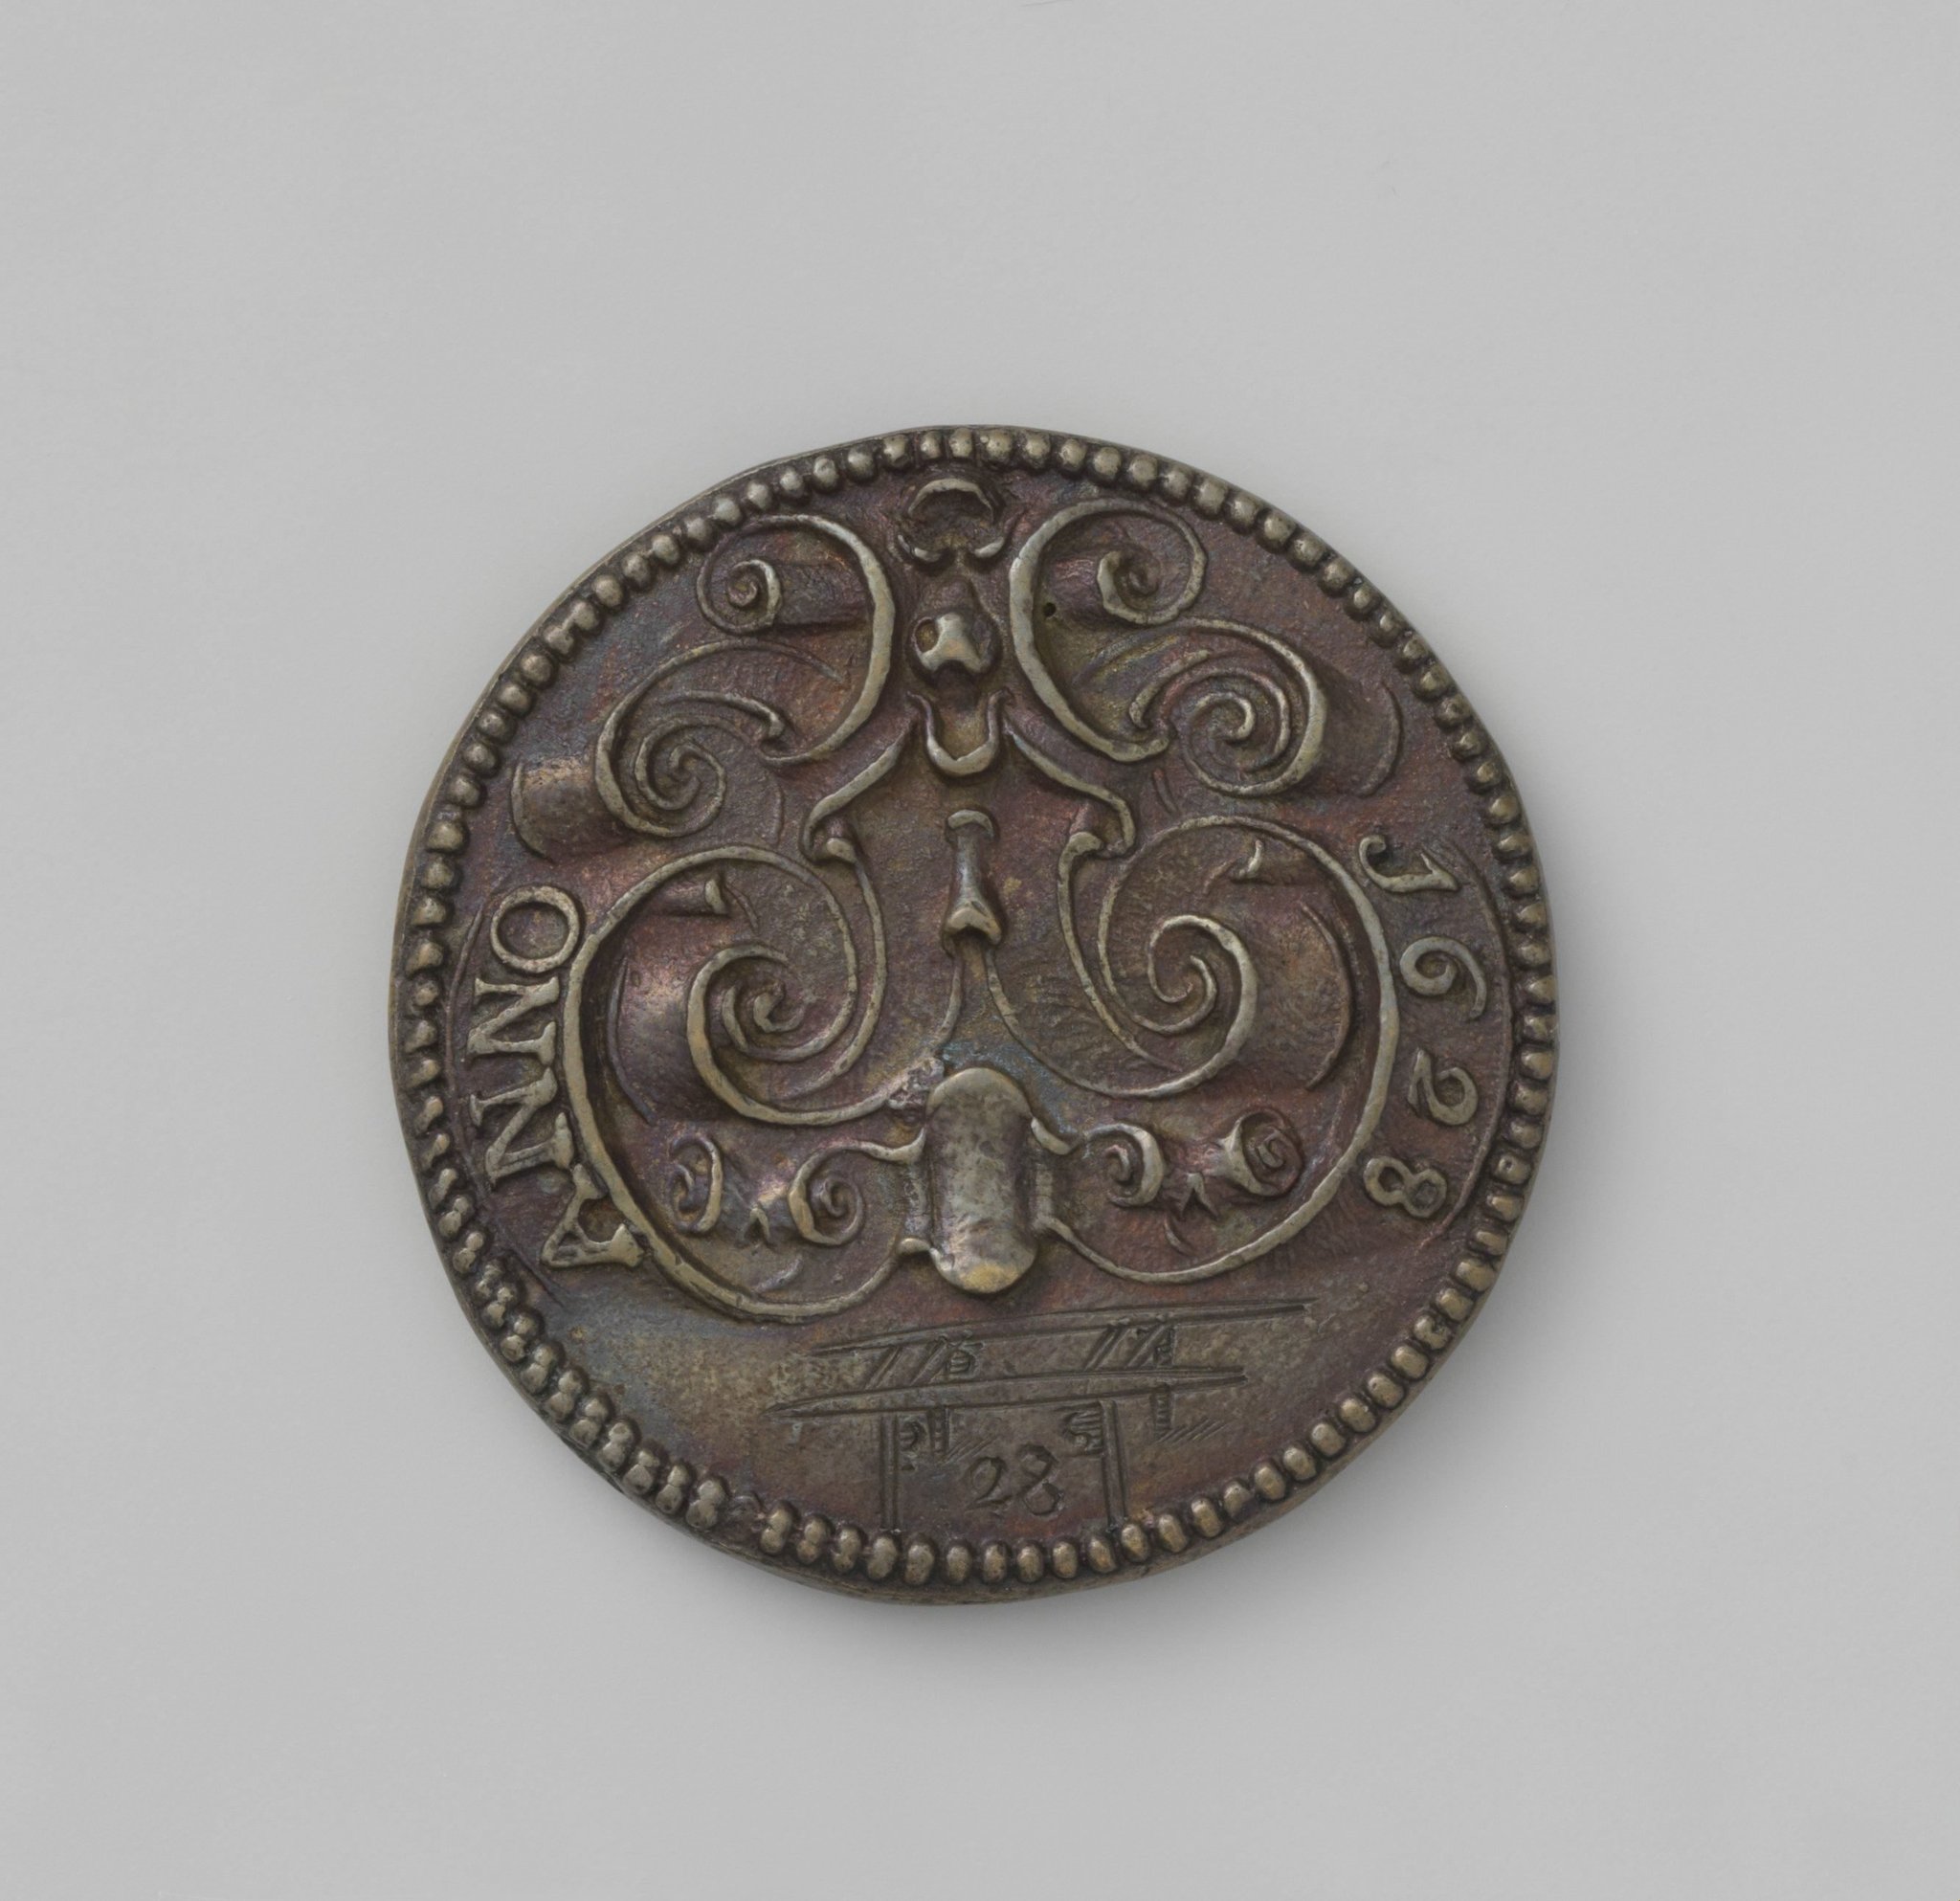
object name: medal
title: Schoolmasters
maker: johannes looff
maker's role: die cutter, draughtsman, print maker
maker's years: -1651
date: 1628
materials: brass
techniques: casting, engraving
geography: middelburg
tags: middelburg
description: Guild medals Members of trade guilds had to identify themselves with a medal at their meetings.